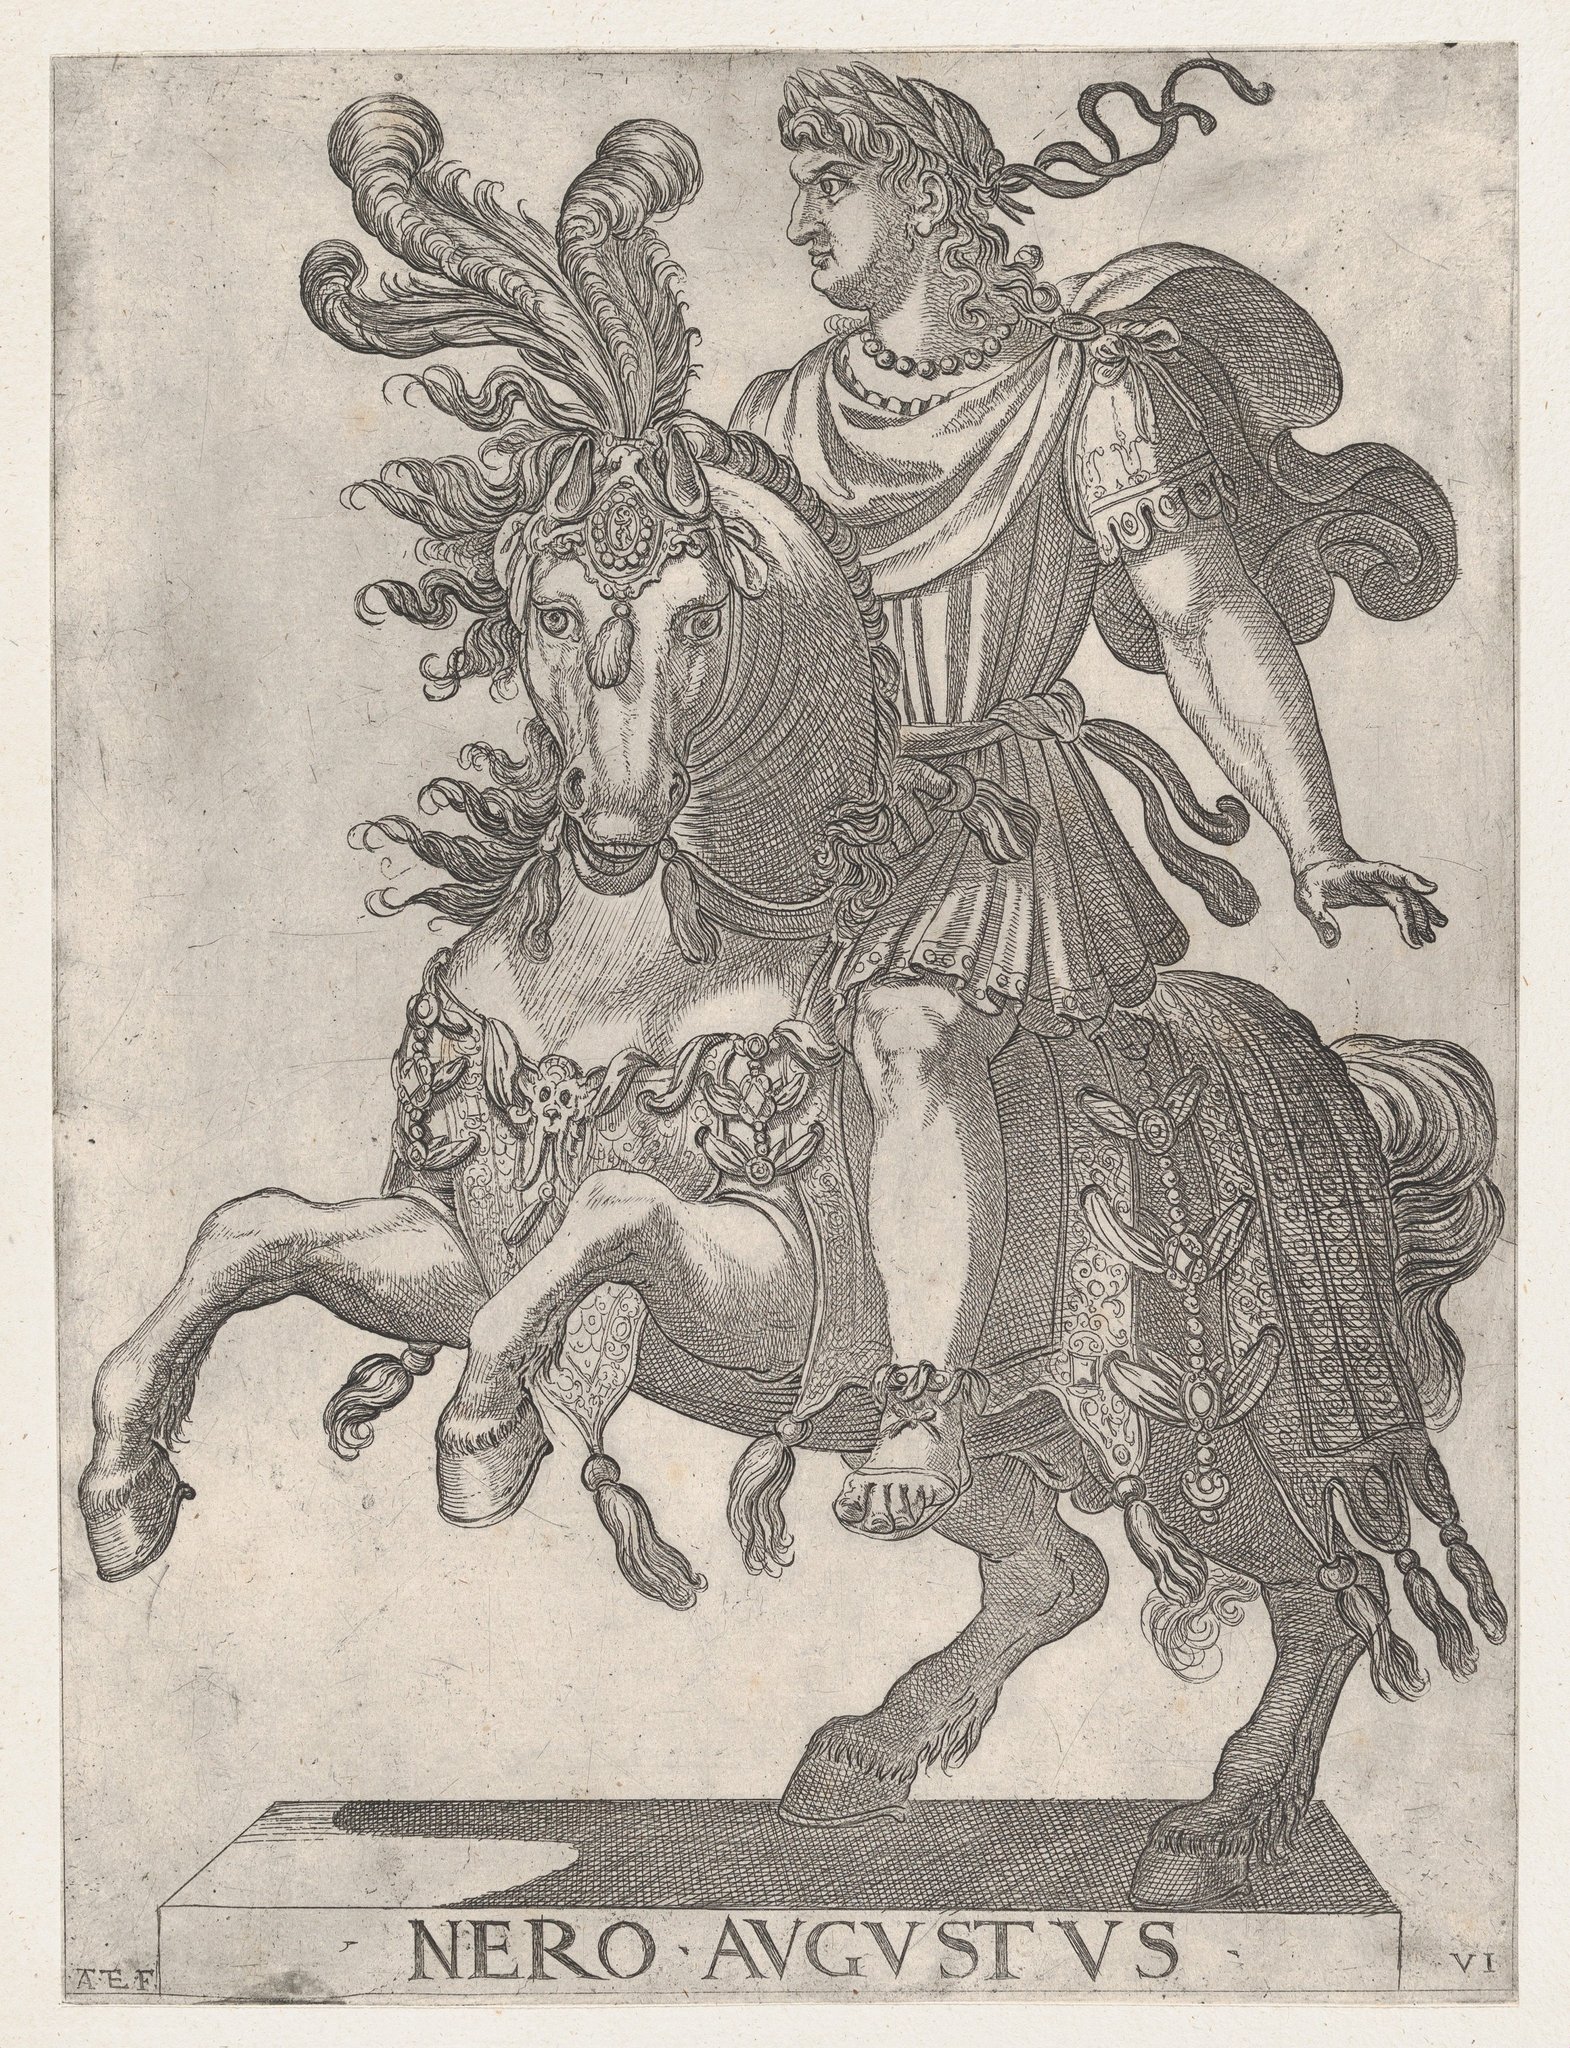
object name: print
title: Plate 6: Emperor Nero on Horseback, from ' The First Twelve Roman Caesars'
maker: antonio tempesta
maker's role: artist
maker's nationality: italian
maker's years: 1555-1630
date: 1596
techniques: etching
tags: nero,horses